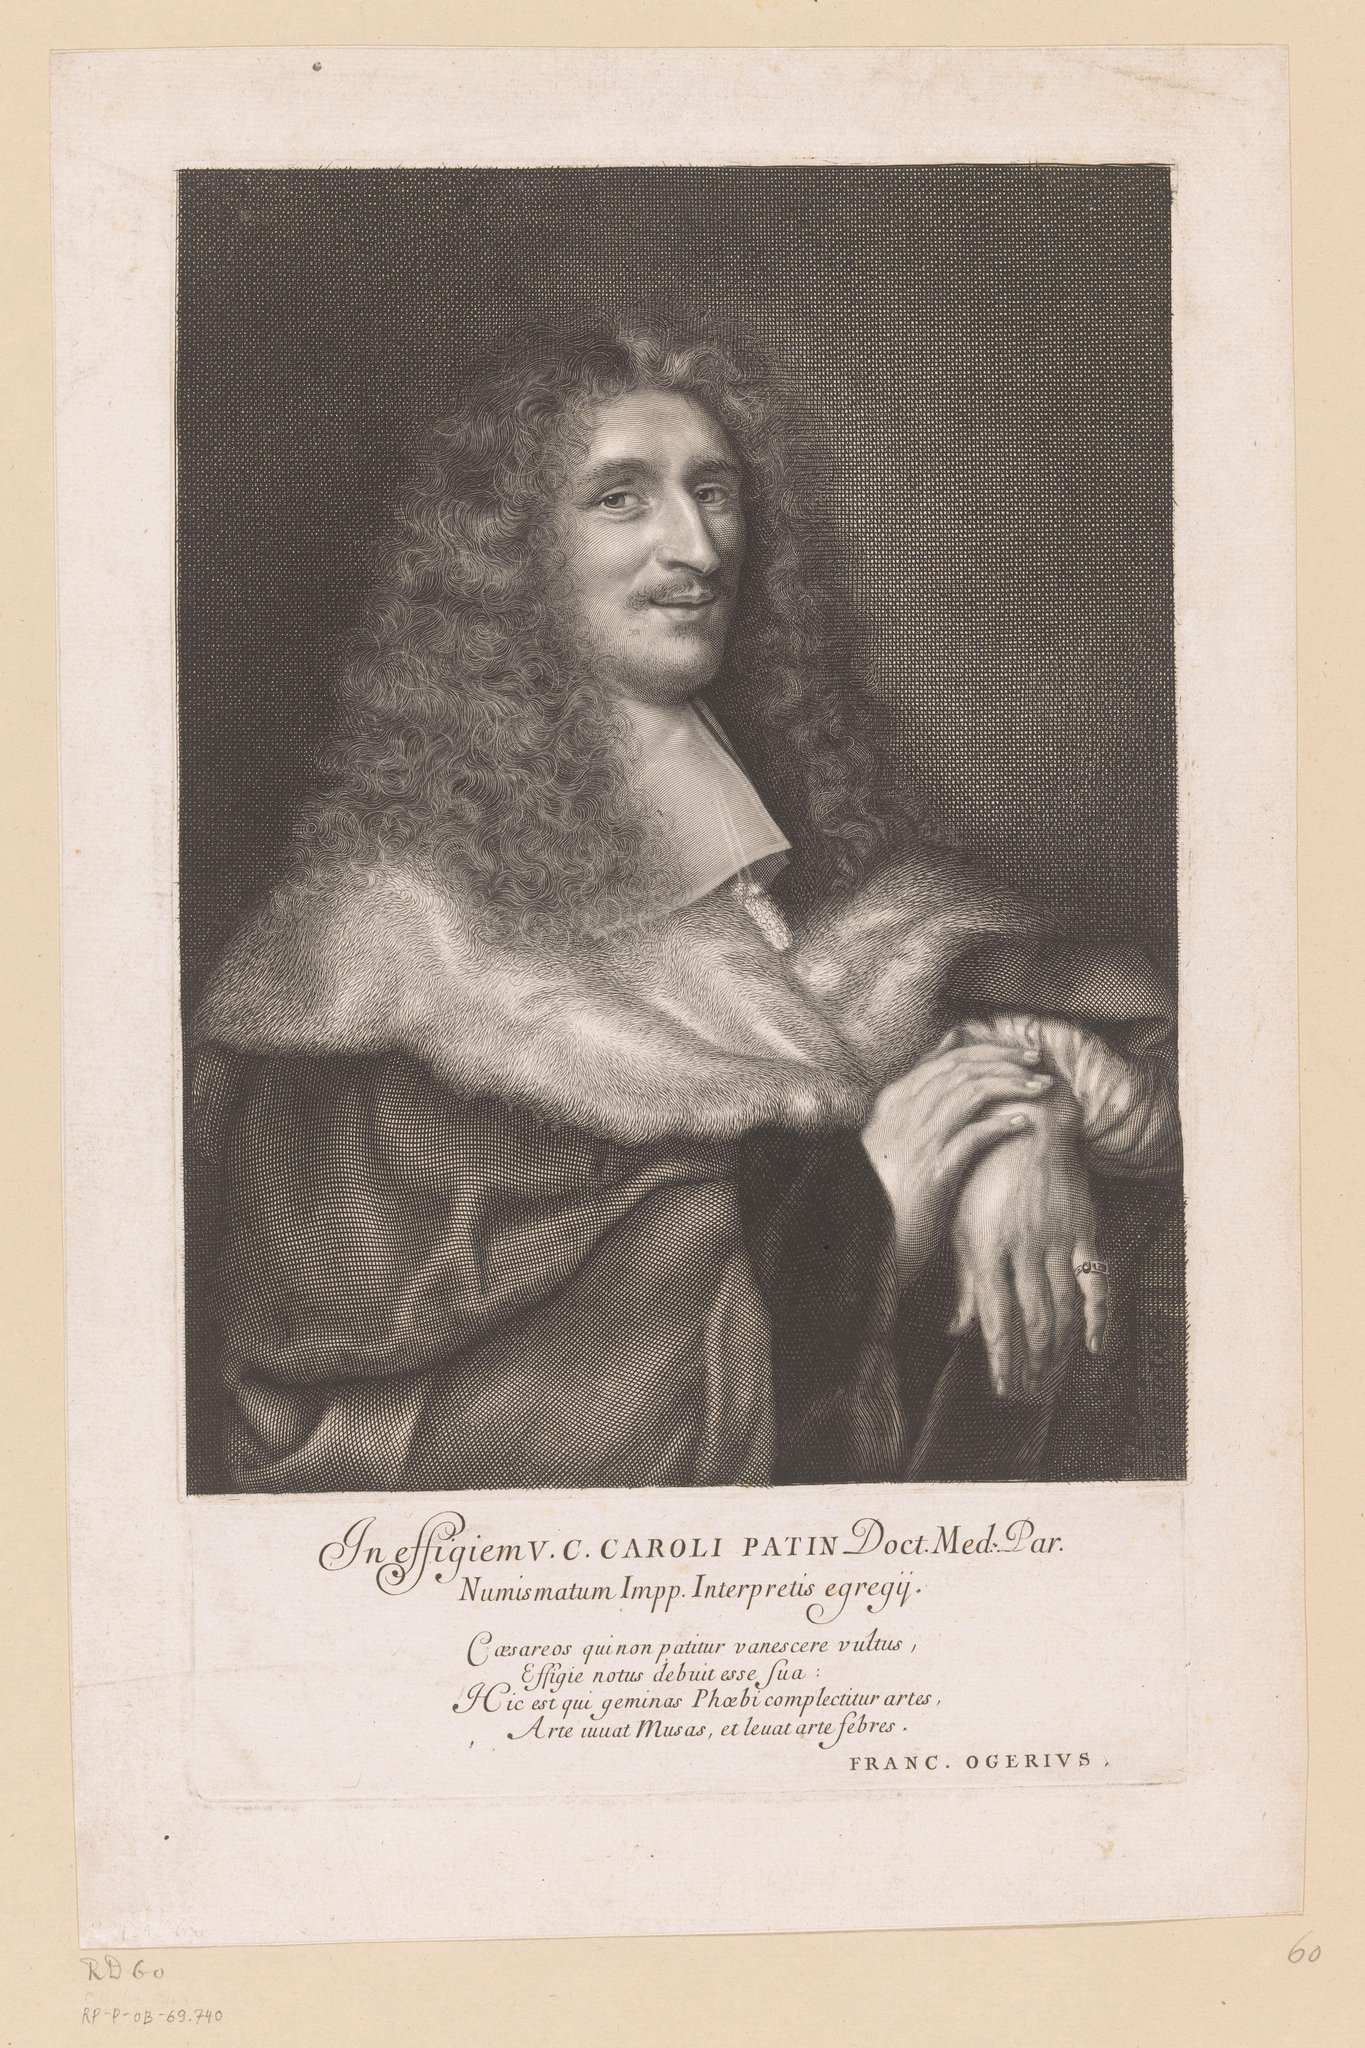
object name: print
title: Portret van Charles Patin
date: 1646-1700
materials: paper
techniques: engraving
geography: france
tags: charles patin, historical persons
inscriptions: collector's mark: Lugt 240